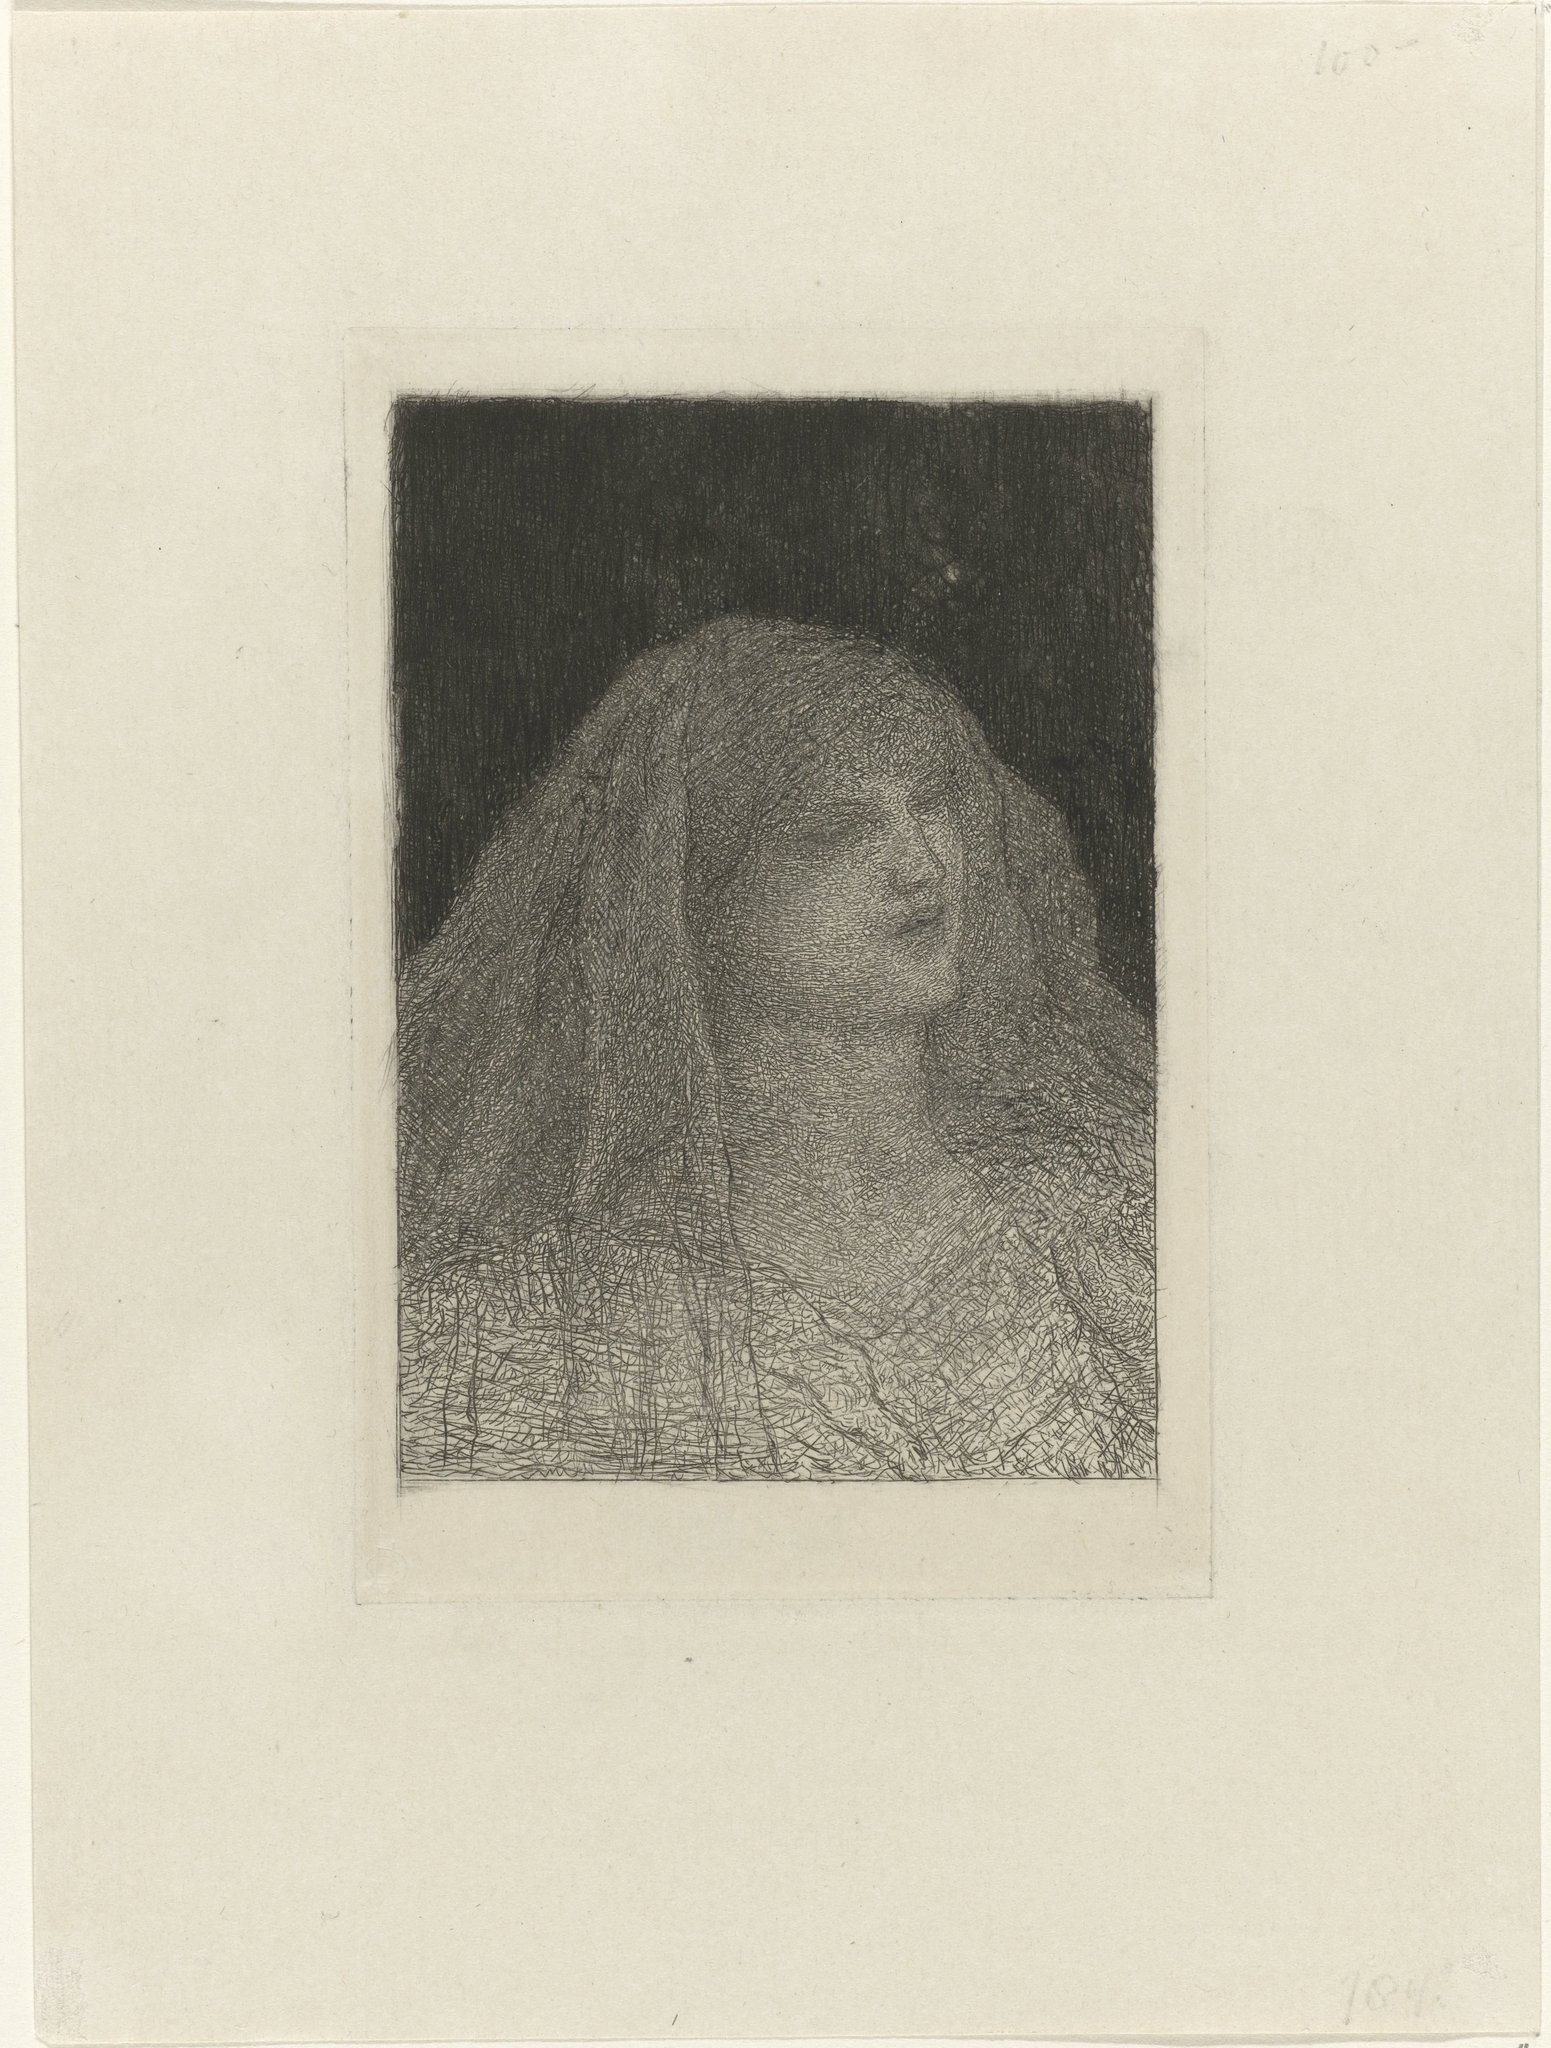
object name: print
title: Vrouw met sluier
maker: matthijs maris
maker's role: draughtsman, painter, print maker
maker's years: 1839-1917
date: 1883-1888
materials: paper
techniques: etching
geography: london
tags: veil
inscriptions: collector's mark: Lugt 526